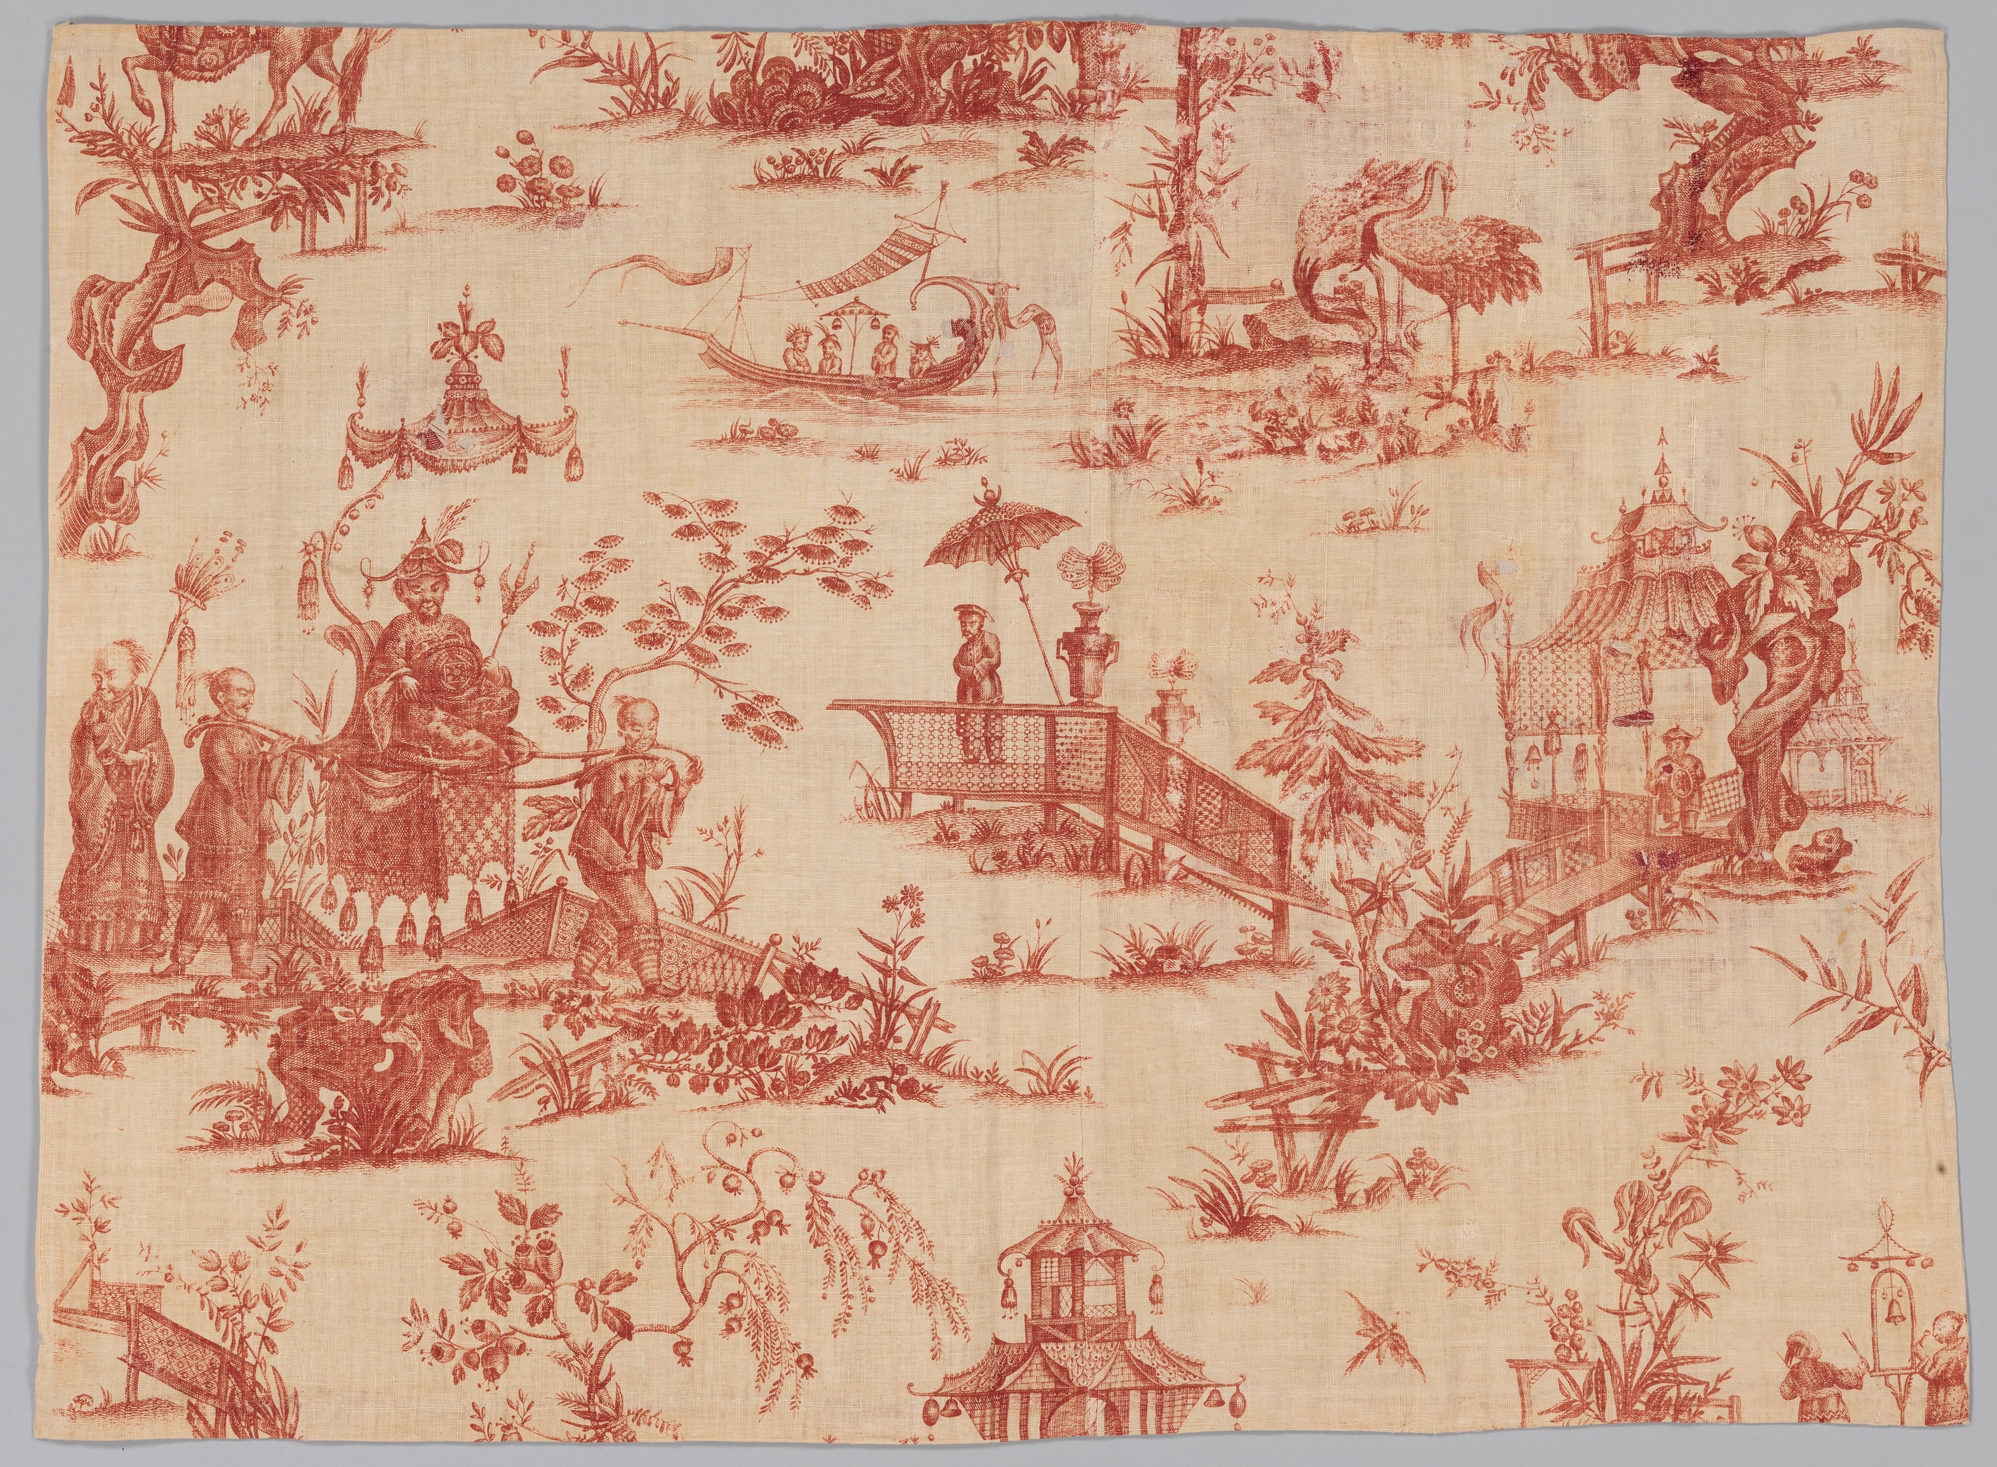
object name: furnishing textile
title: Pictorial print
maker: jean-baptiste huet i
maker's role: designer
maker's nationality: french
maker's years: 1745-1811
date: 1786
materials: linen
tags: birds,chinoiserie,men,boats